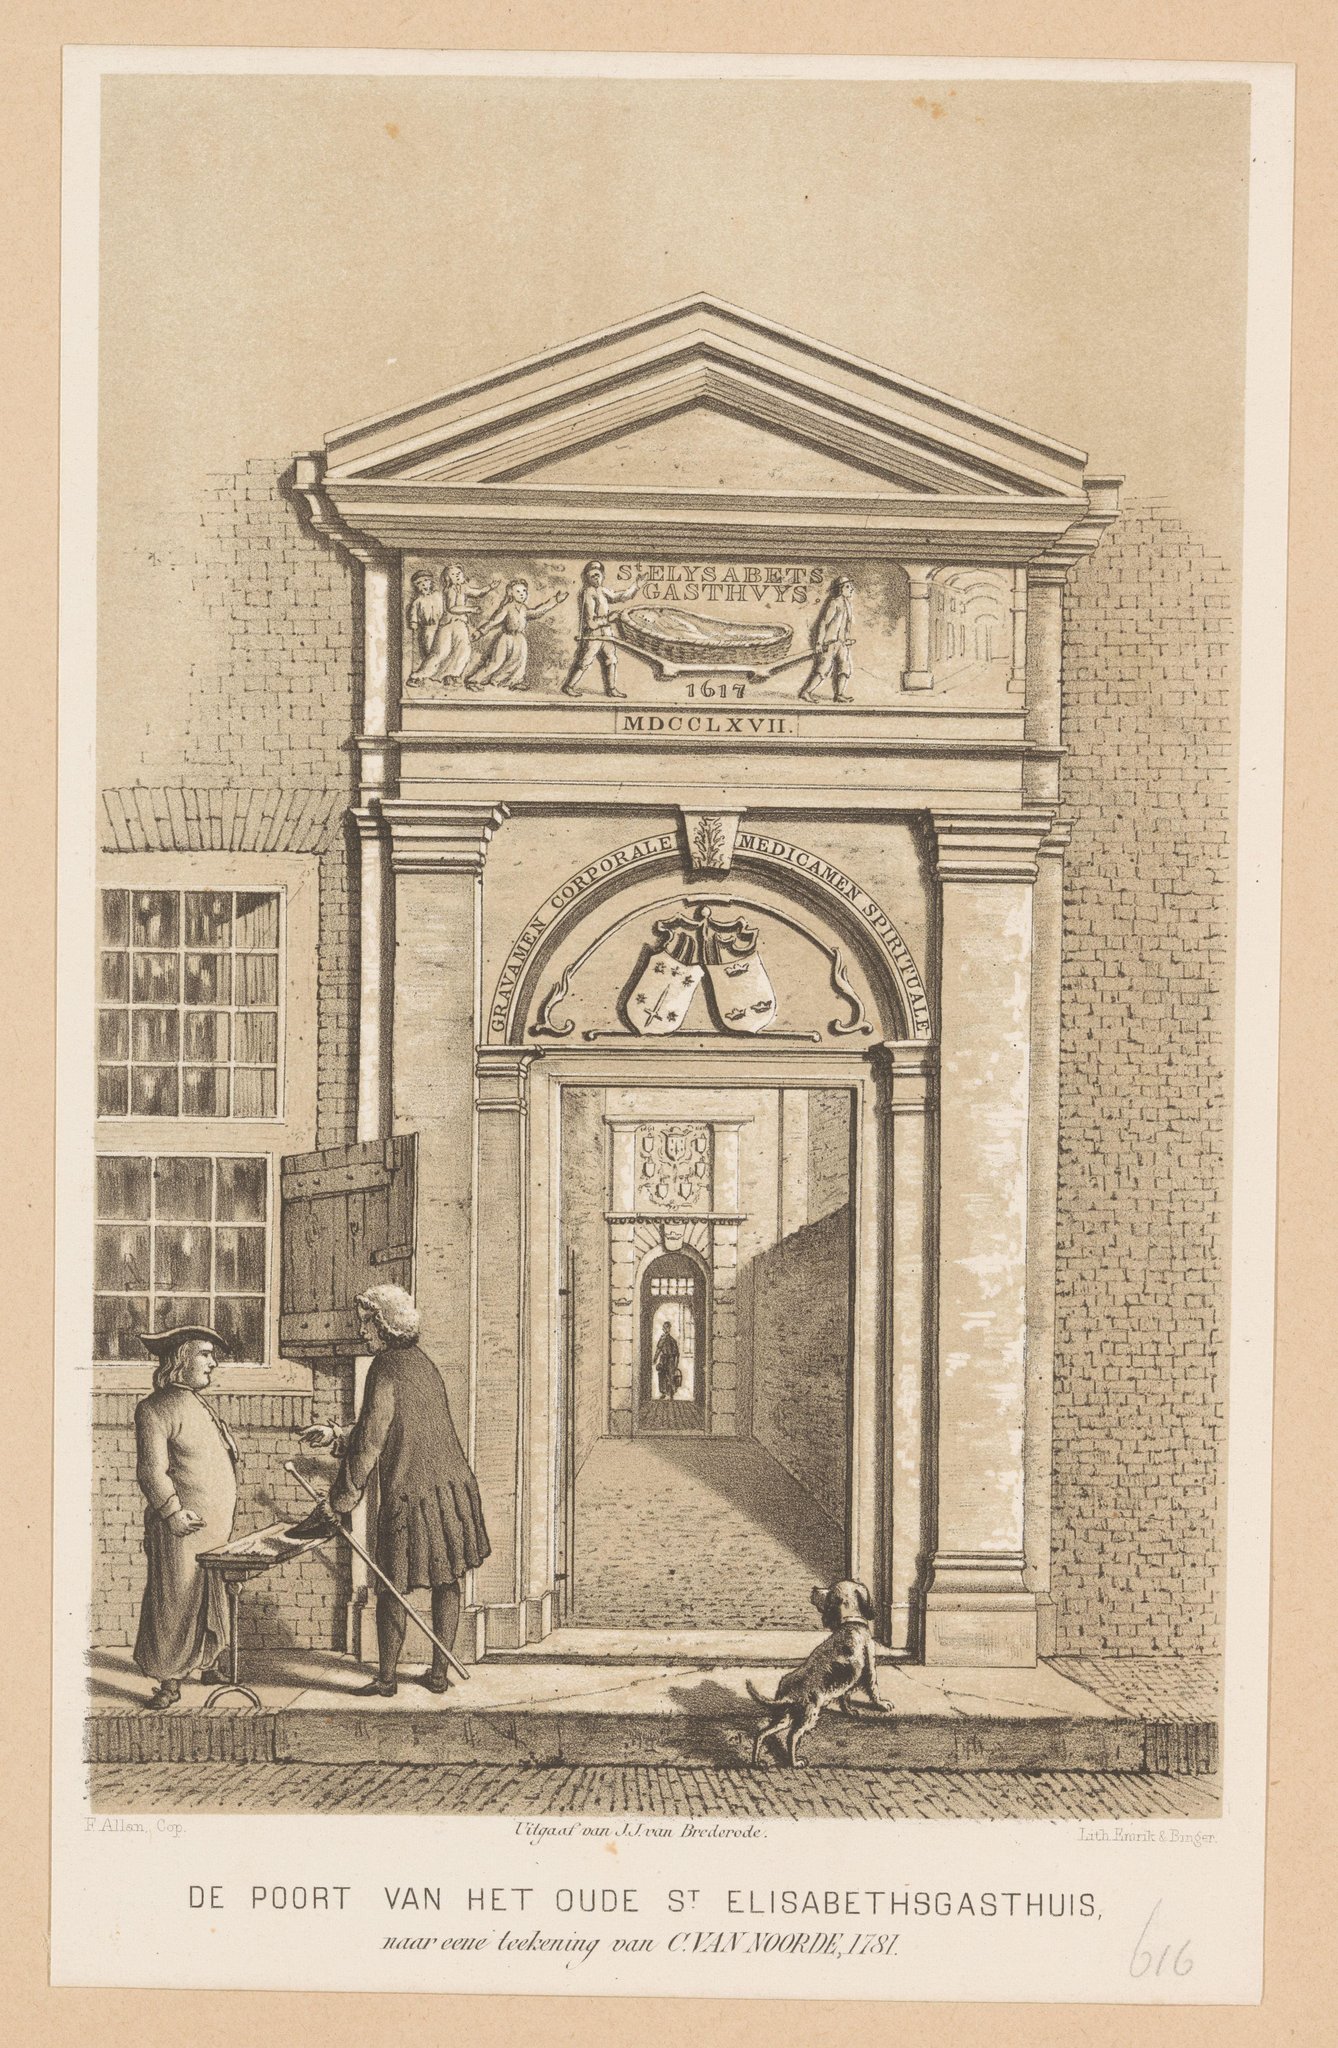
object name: print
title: De poort van het oude St. Elisabethsgasthuis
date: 1874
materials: paper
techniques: tone lithography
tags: monumental door, porch, 'aediculum', hospital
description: Prent uit: Allan, Francis. Geschiedenis en beschrijving van Haarlem (...). 4 dln. 1874-1888, dl. 1 (1874), p. 262-263.